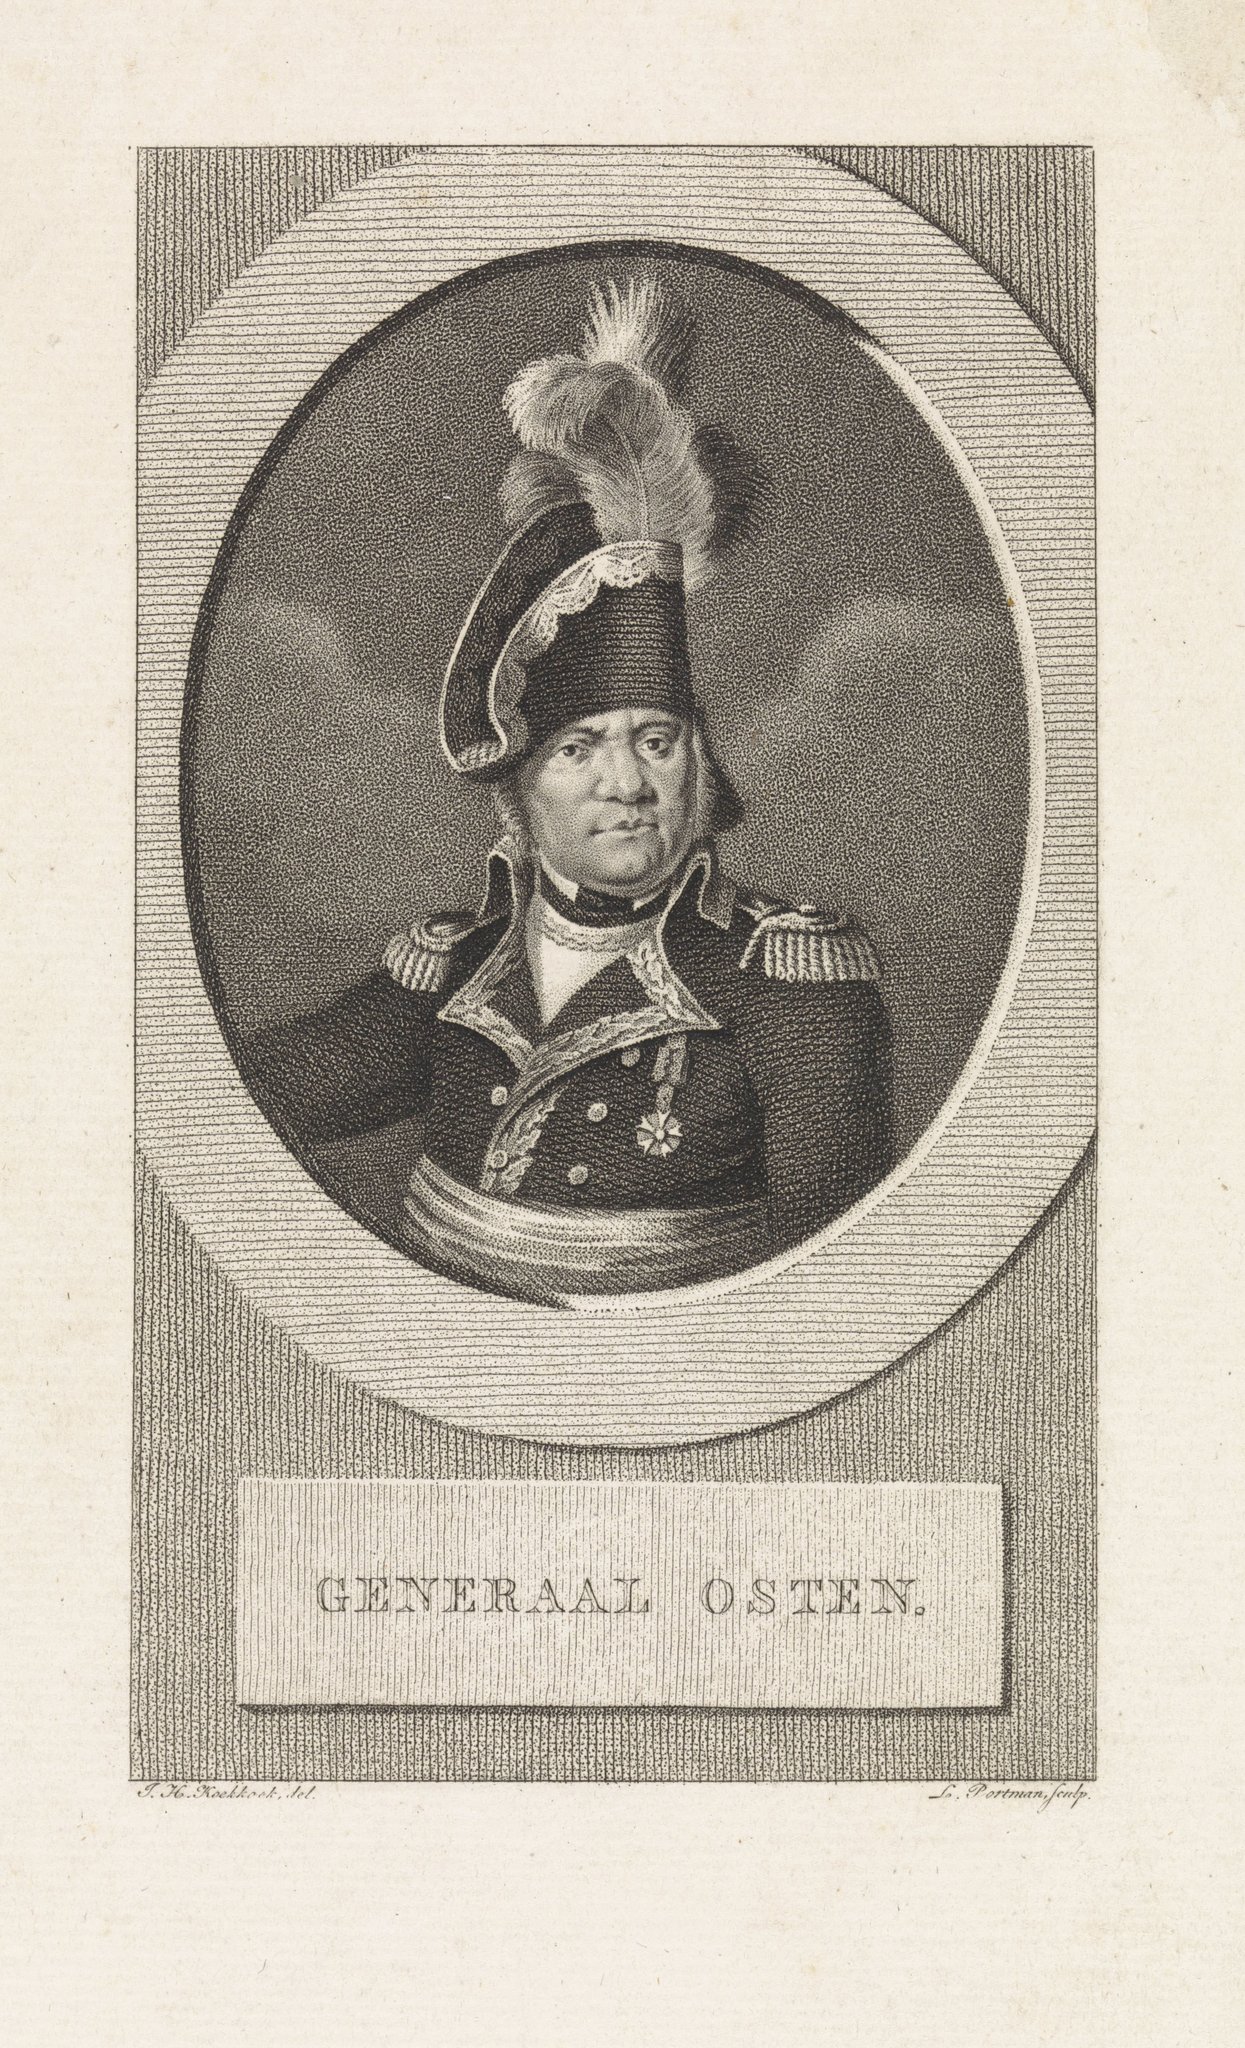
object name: print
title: Portret van de generaal Pierre-Jacques Osten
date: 1787-1828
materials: paper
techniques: etching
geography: netherlands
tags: menin, generaal, pierre-jacques osten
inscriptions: collector's mark: Lugt 2228